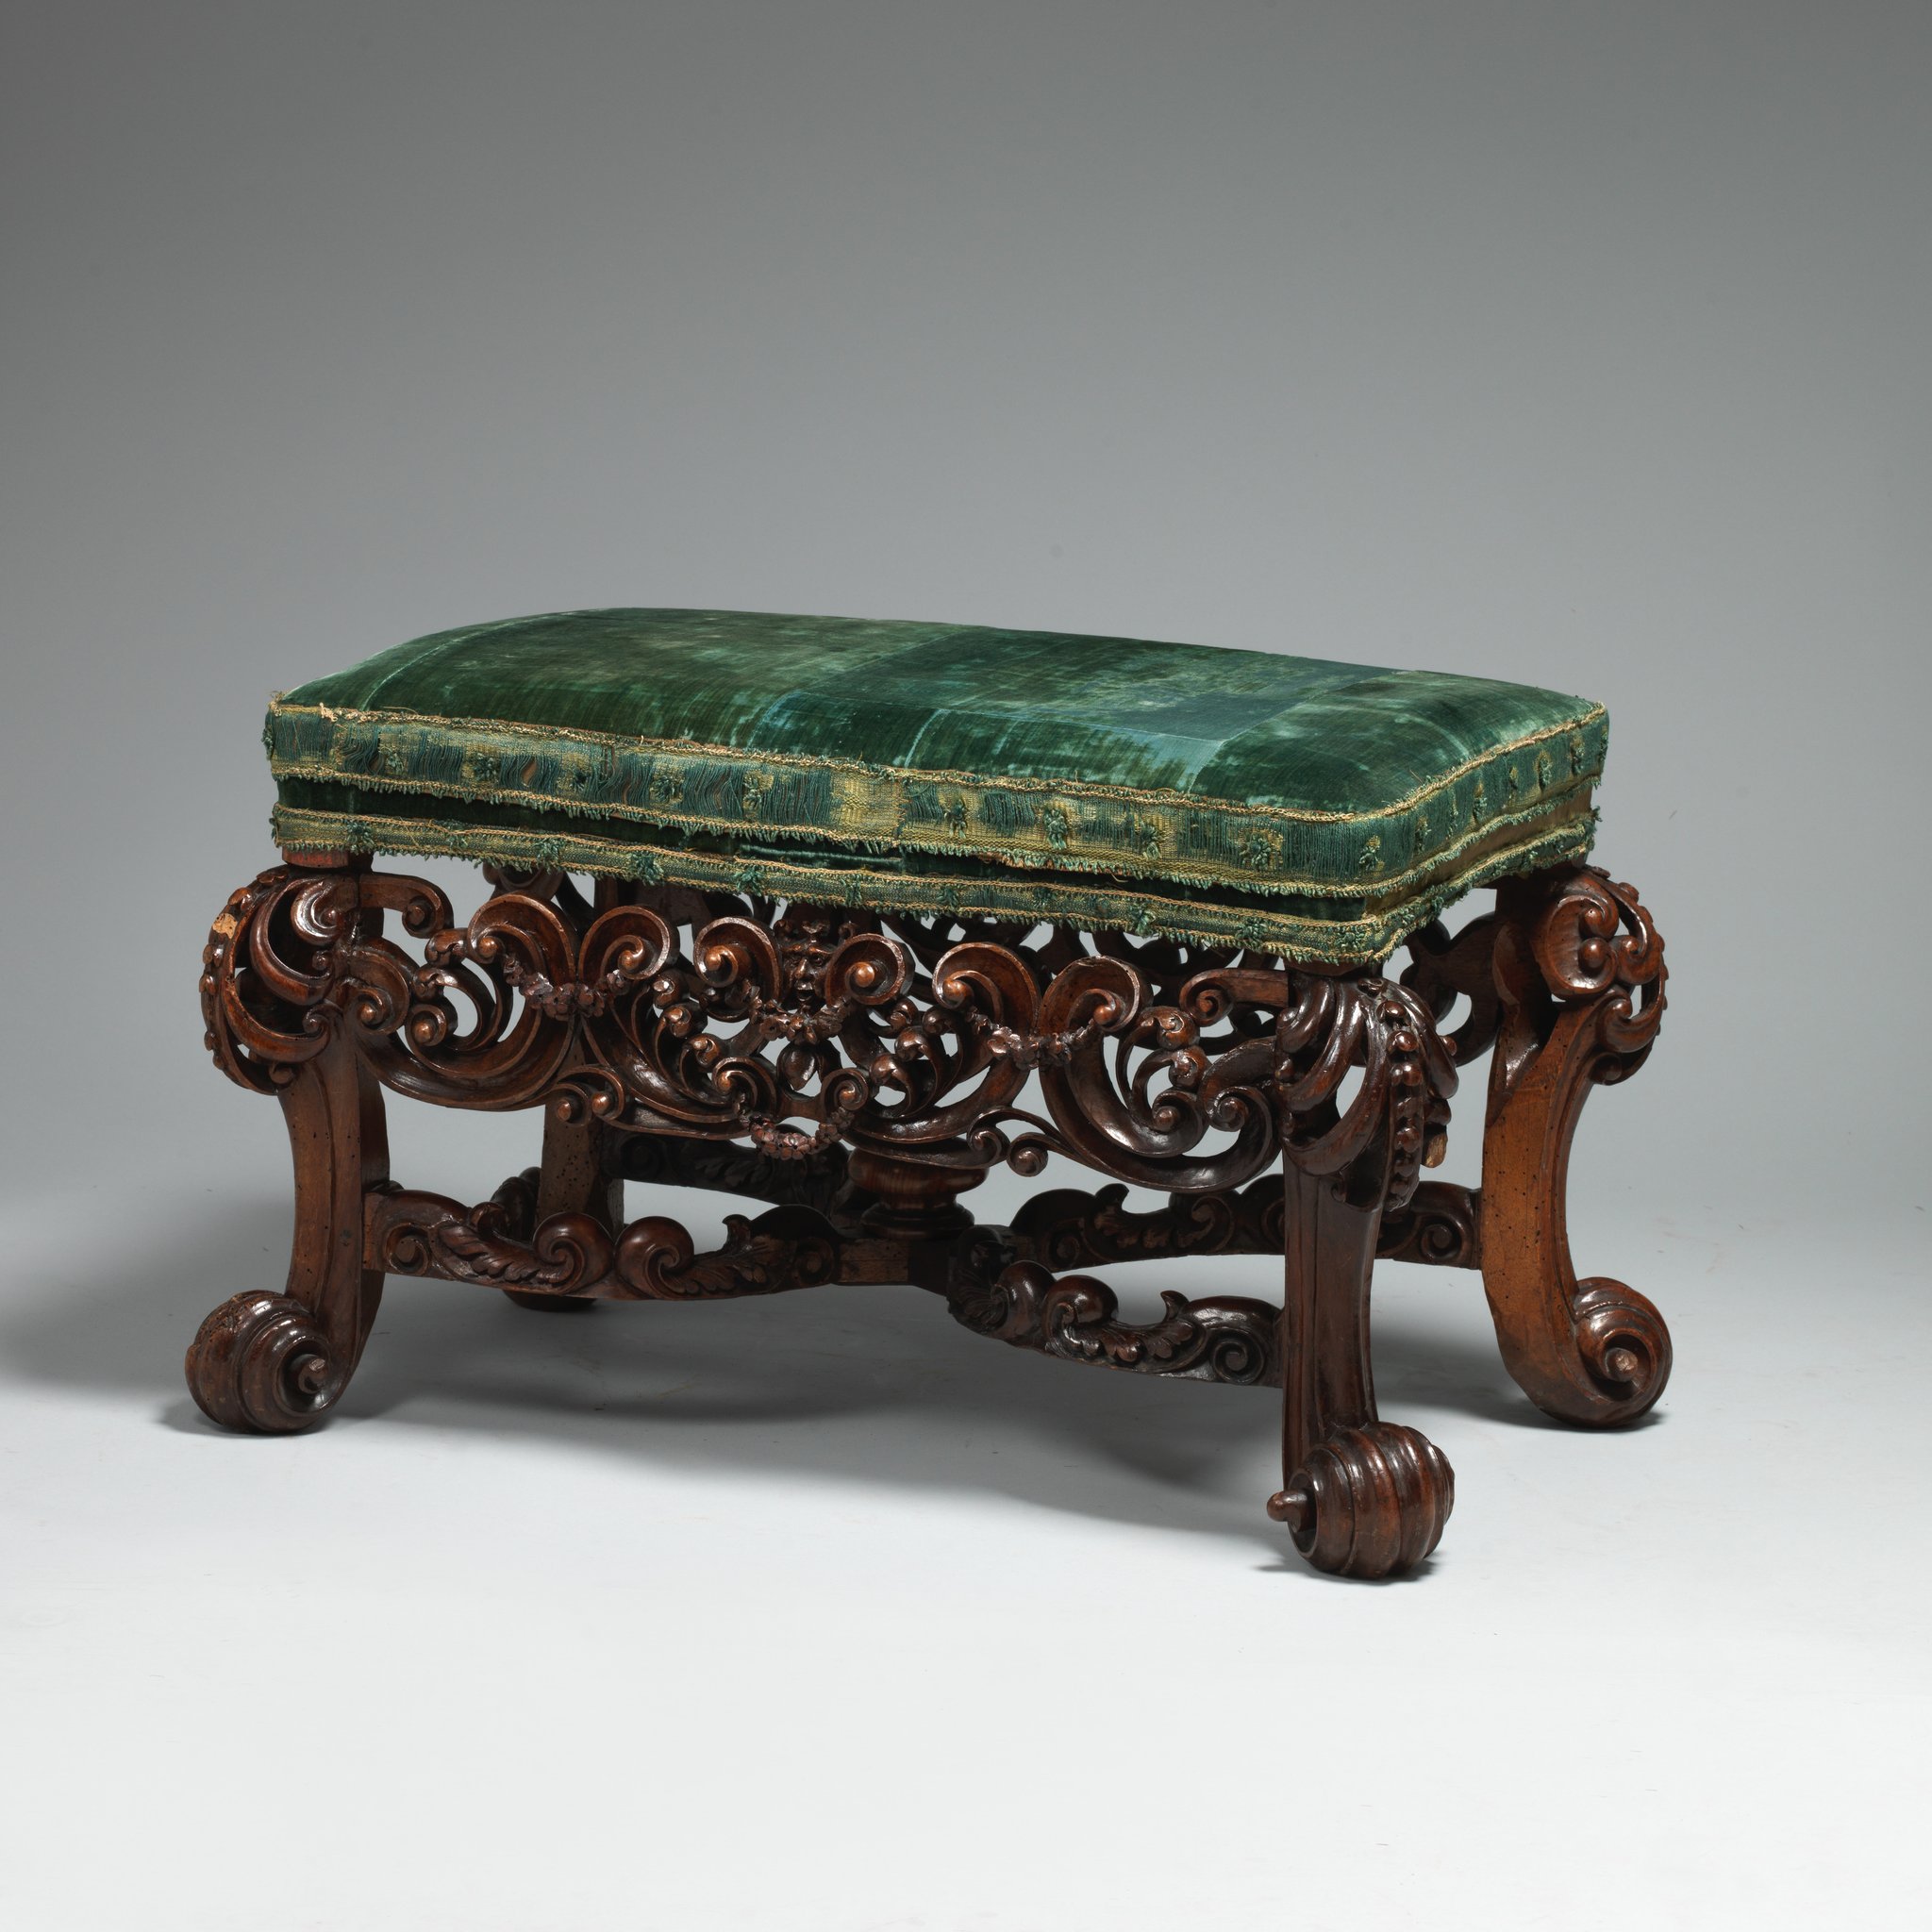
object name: stool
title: Stool (one of a pair)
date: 1690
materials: velvet, wood